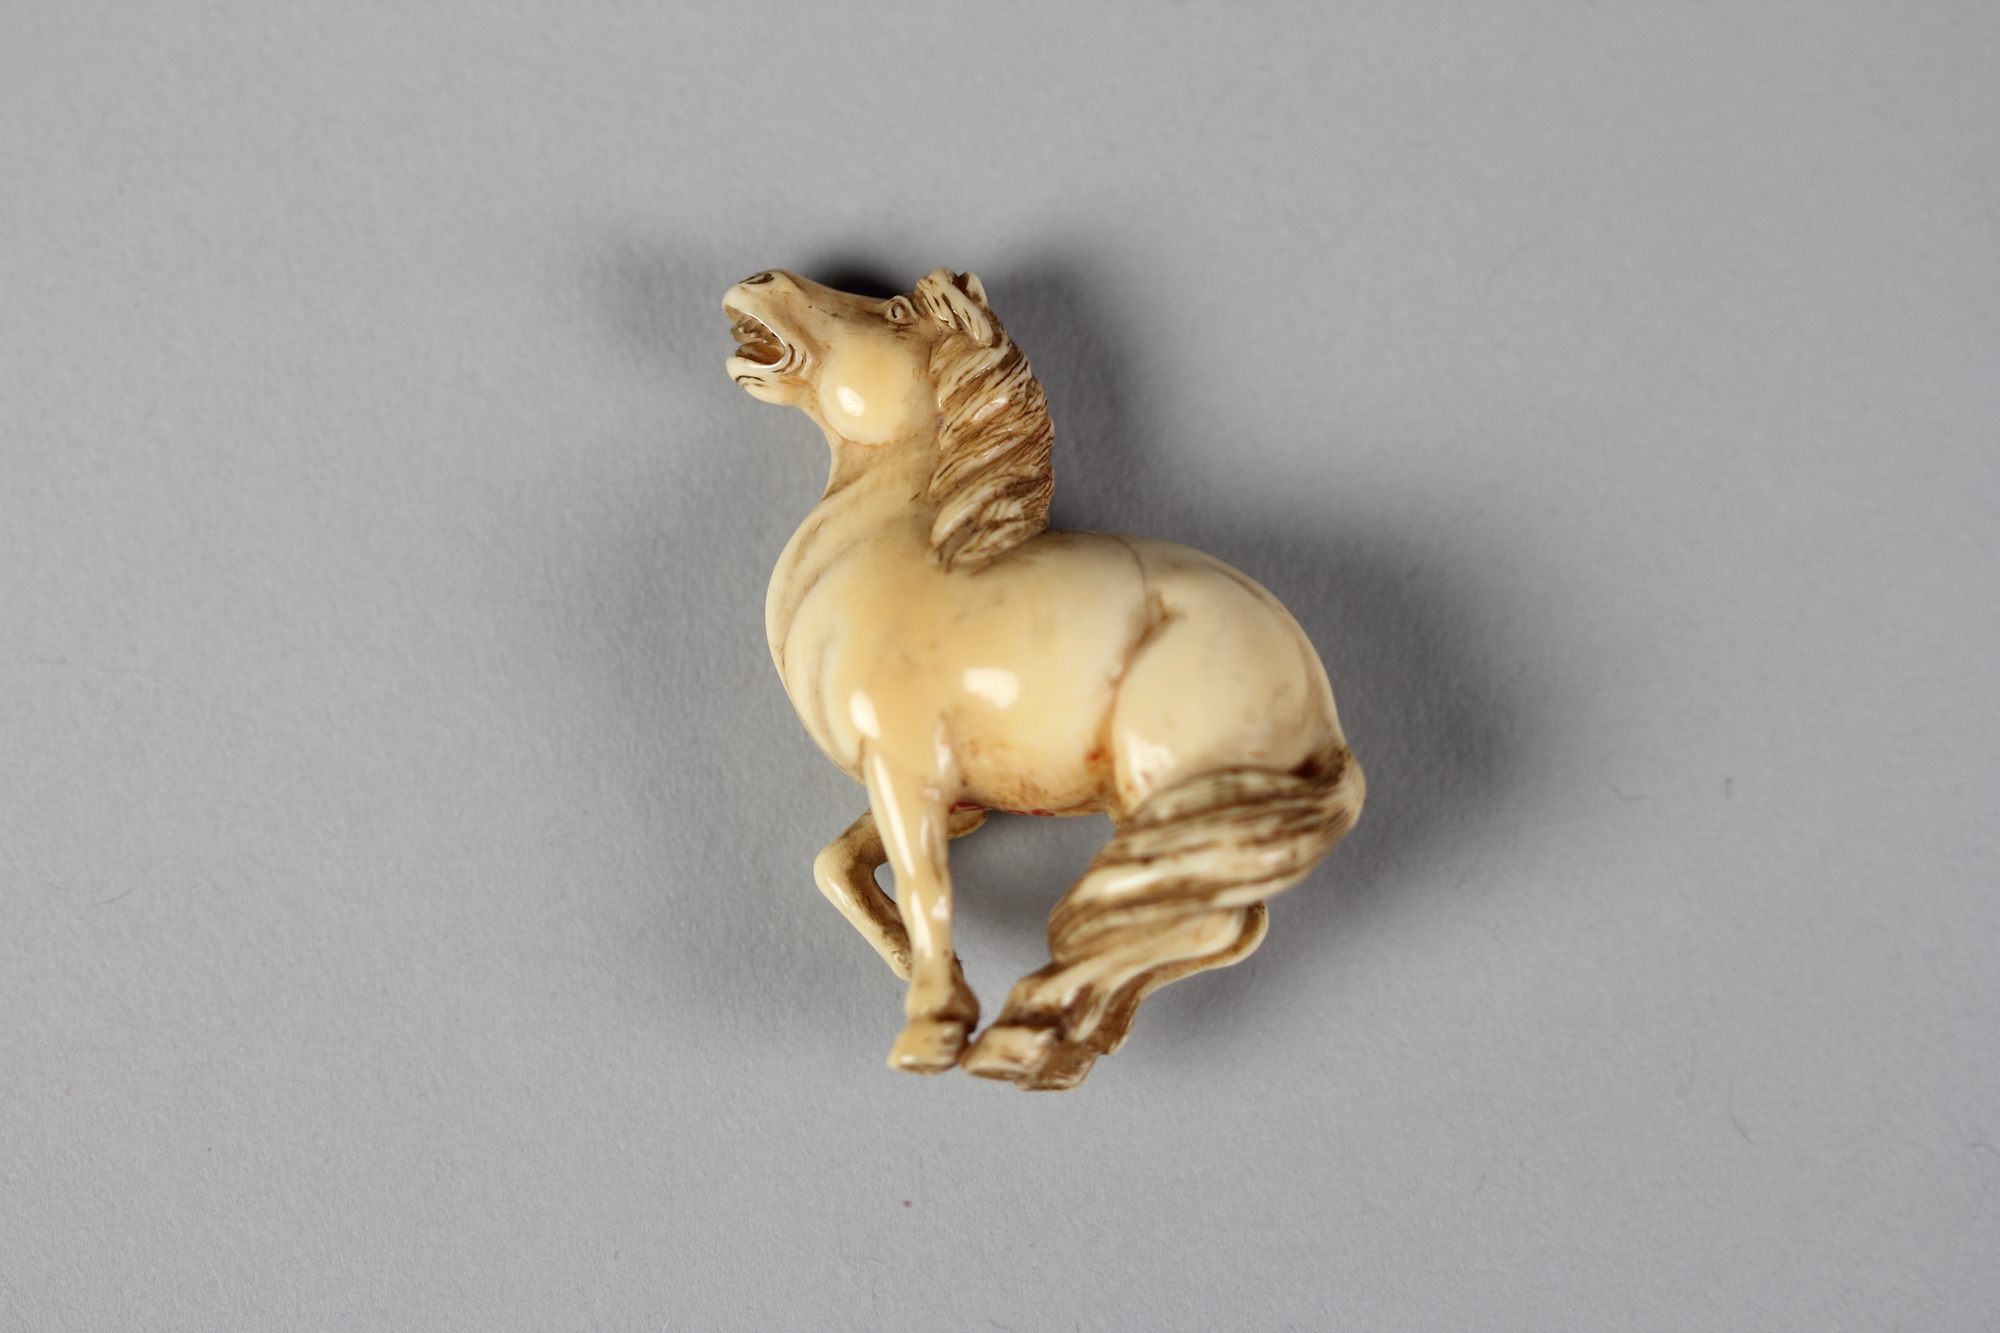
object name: netsuke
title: Netsuke of Horse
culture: japanese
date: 1801-1900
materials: ivory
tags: horses